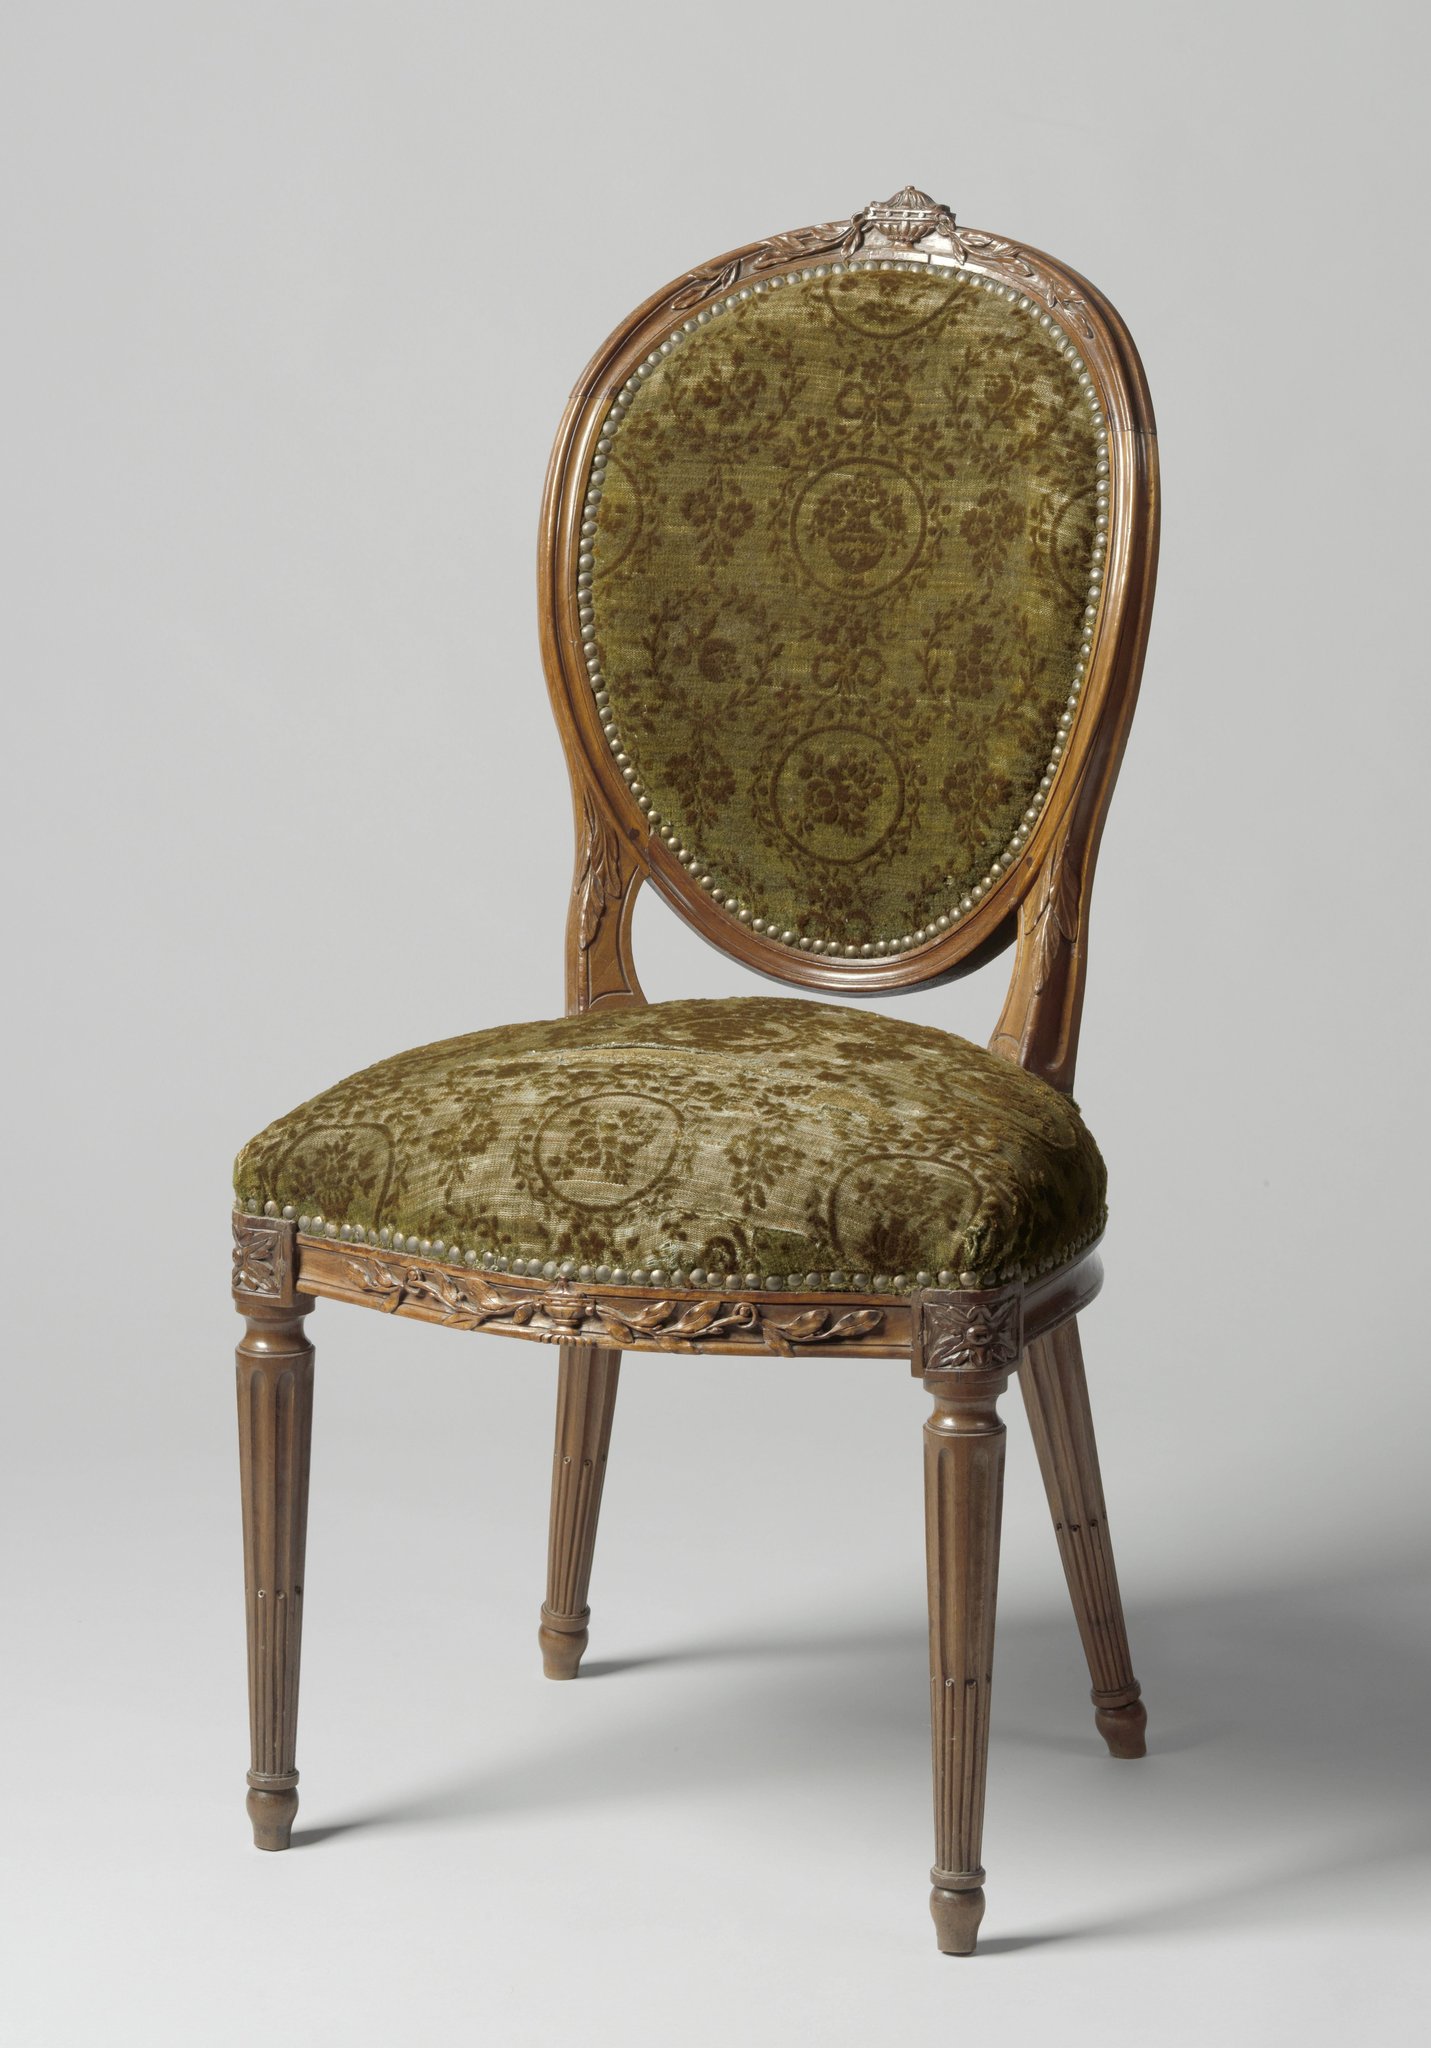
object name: chair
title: Stoel van mahoniehout, bekleed met groene trijp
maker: Anonymous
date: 1775-1800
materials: wood, textile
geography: netherlands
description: Armchair. Mahogany, the velvet upholstery has been renewed. Netherlands, c. 1780 - 1800. Given by Mr and Mrs Drucker-Fraser, 1922.